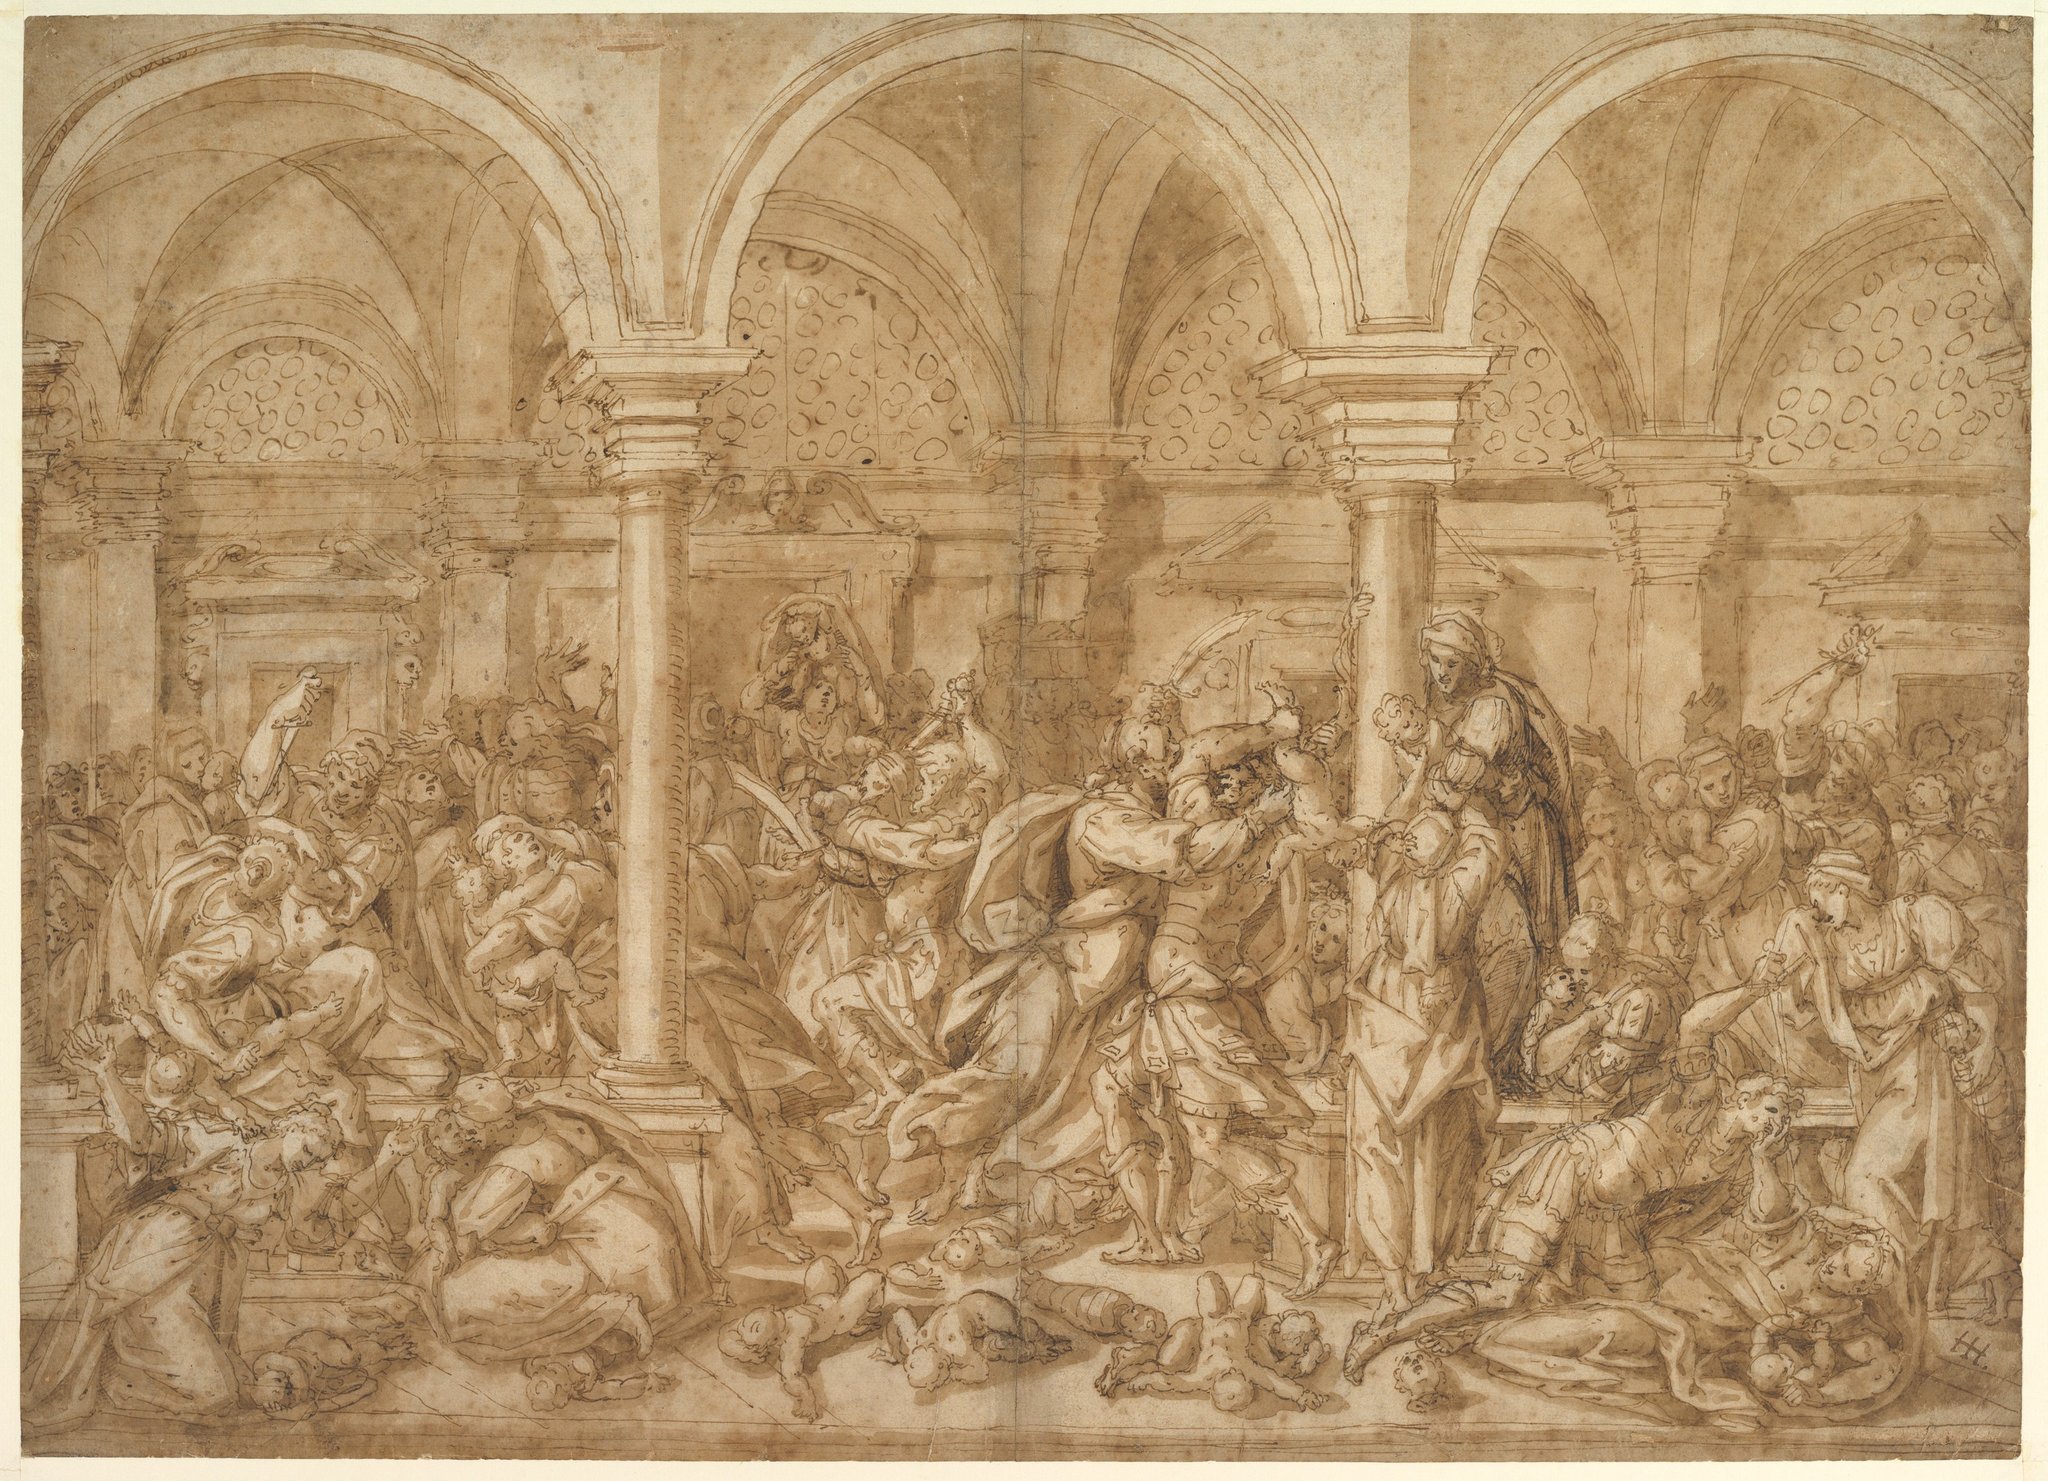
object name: drawing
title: The Massacre of the Innocents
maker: giovanni battista della rovere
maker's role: artist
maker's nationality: italian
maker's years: 1575-1630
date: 1590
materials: chalk, ink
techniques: brush, pen, wash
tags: human figures,massacres,children